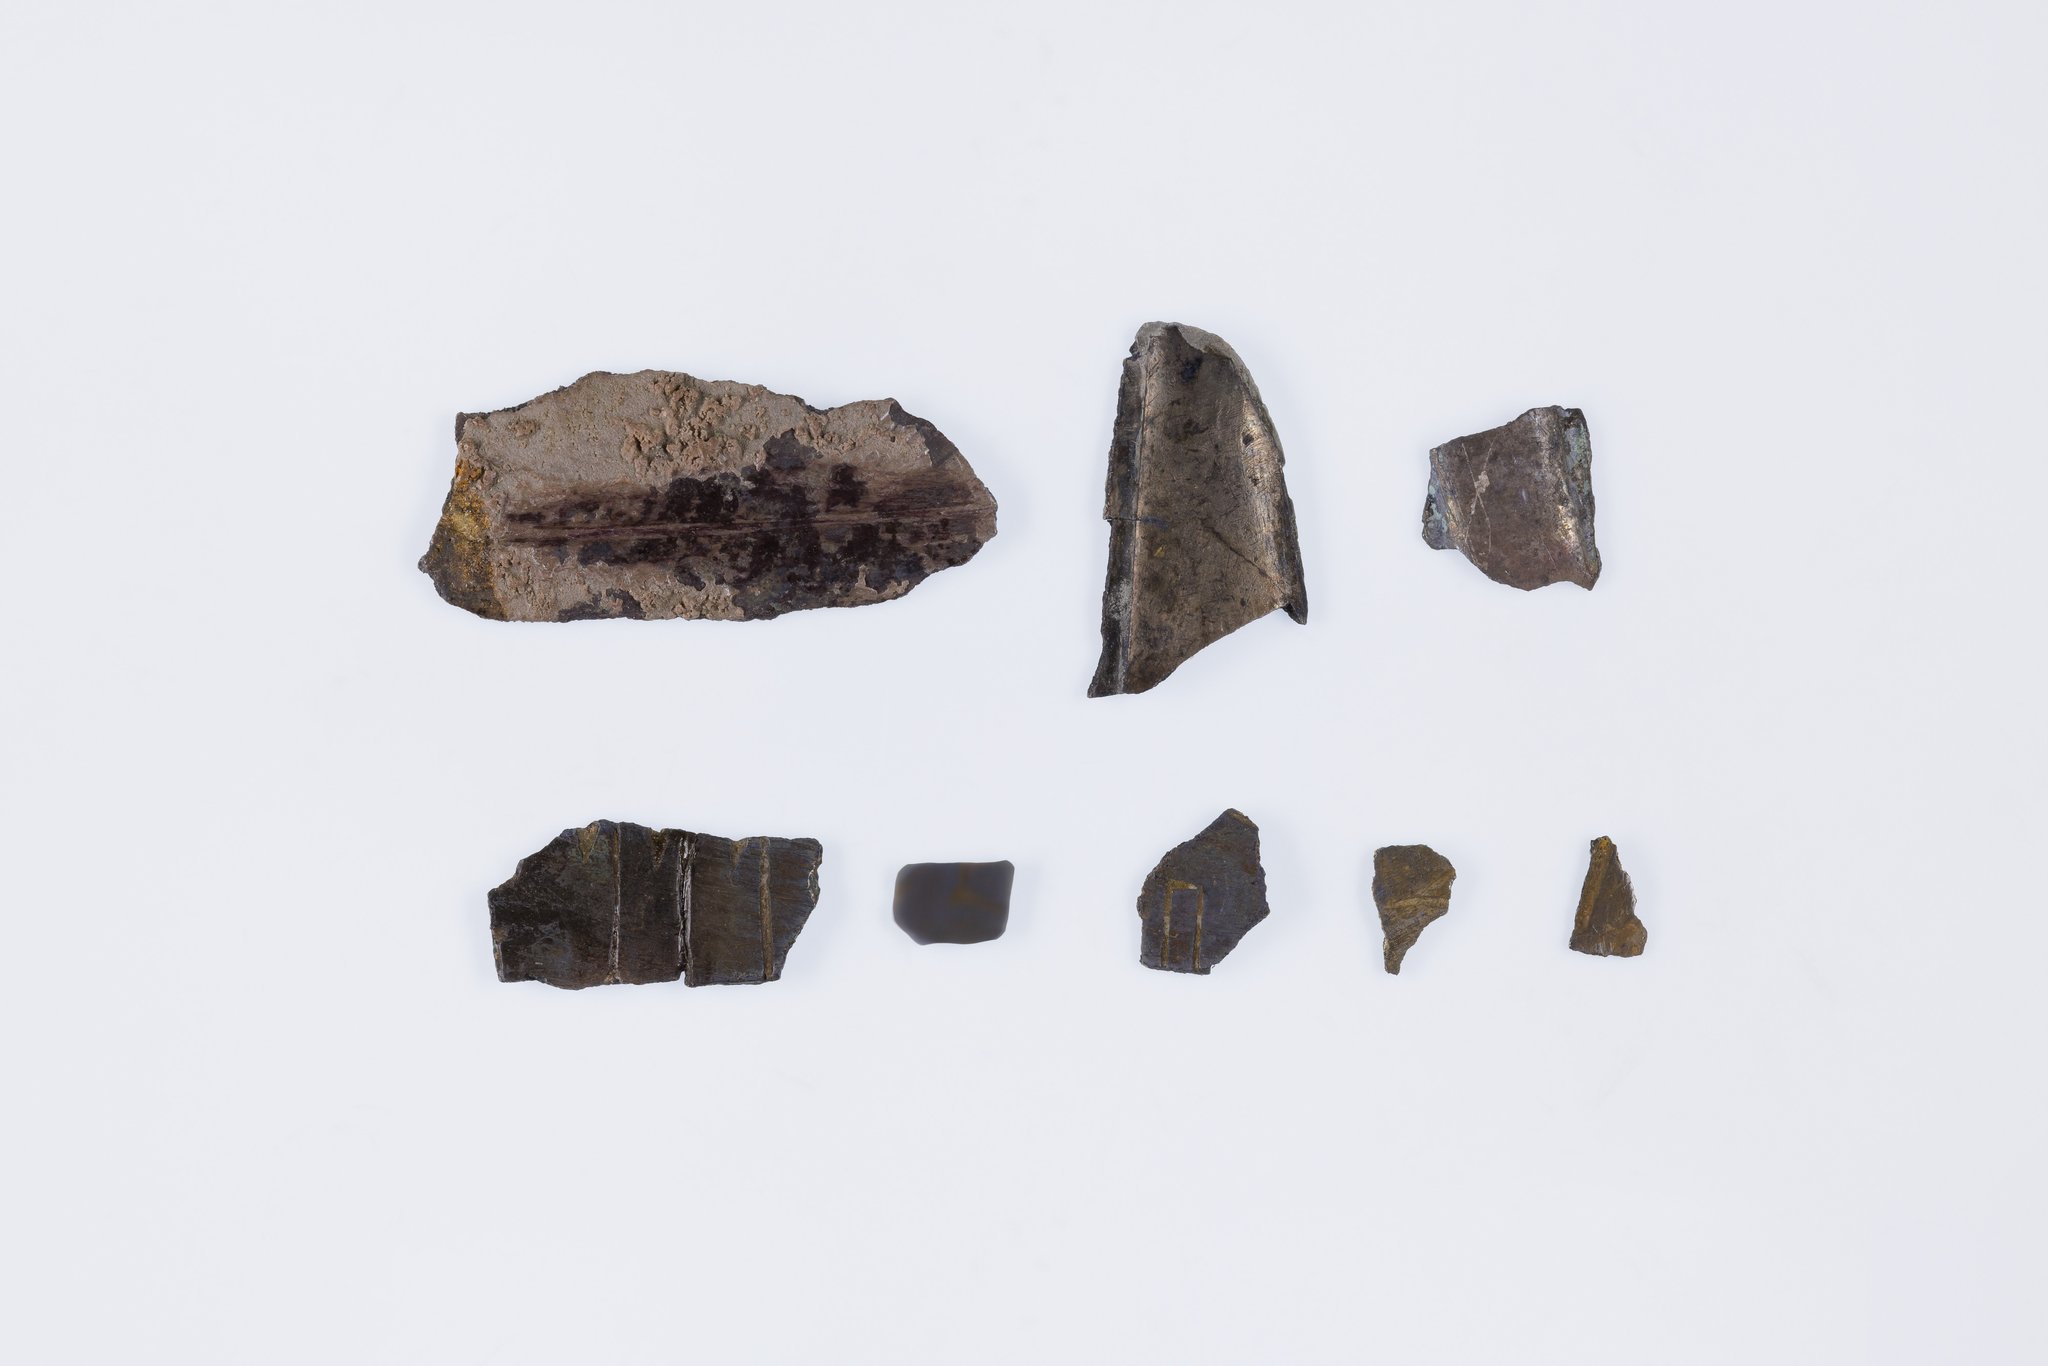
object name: vessel fragment, tell basta treasure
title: Vessel fragments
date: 1070-712 BCE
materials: silver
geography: egypt